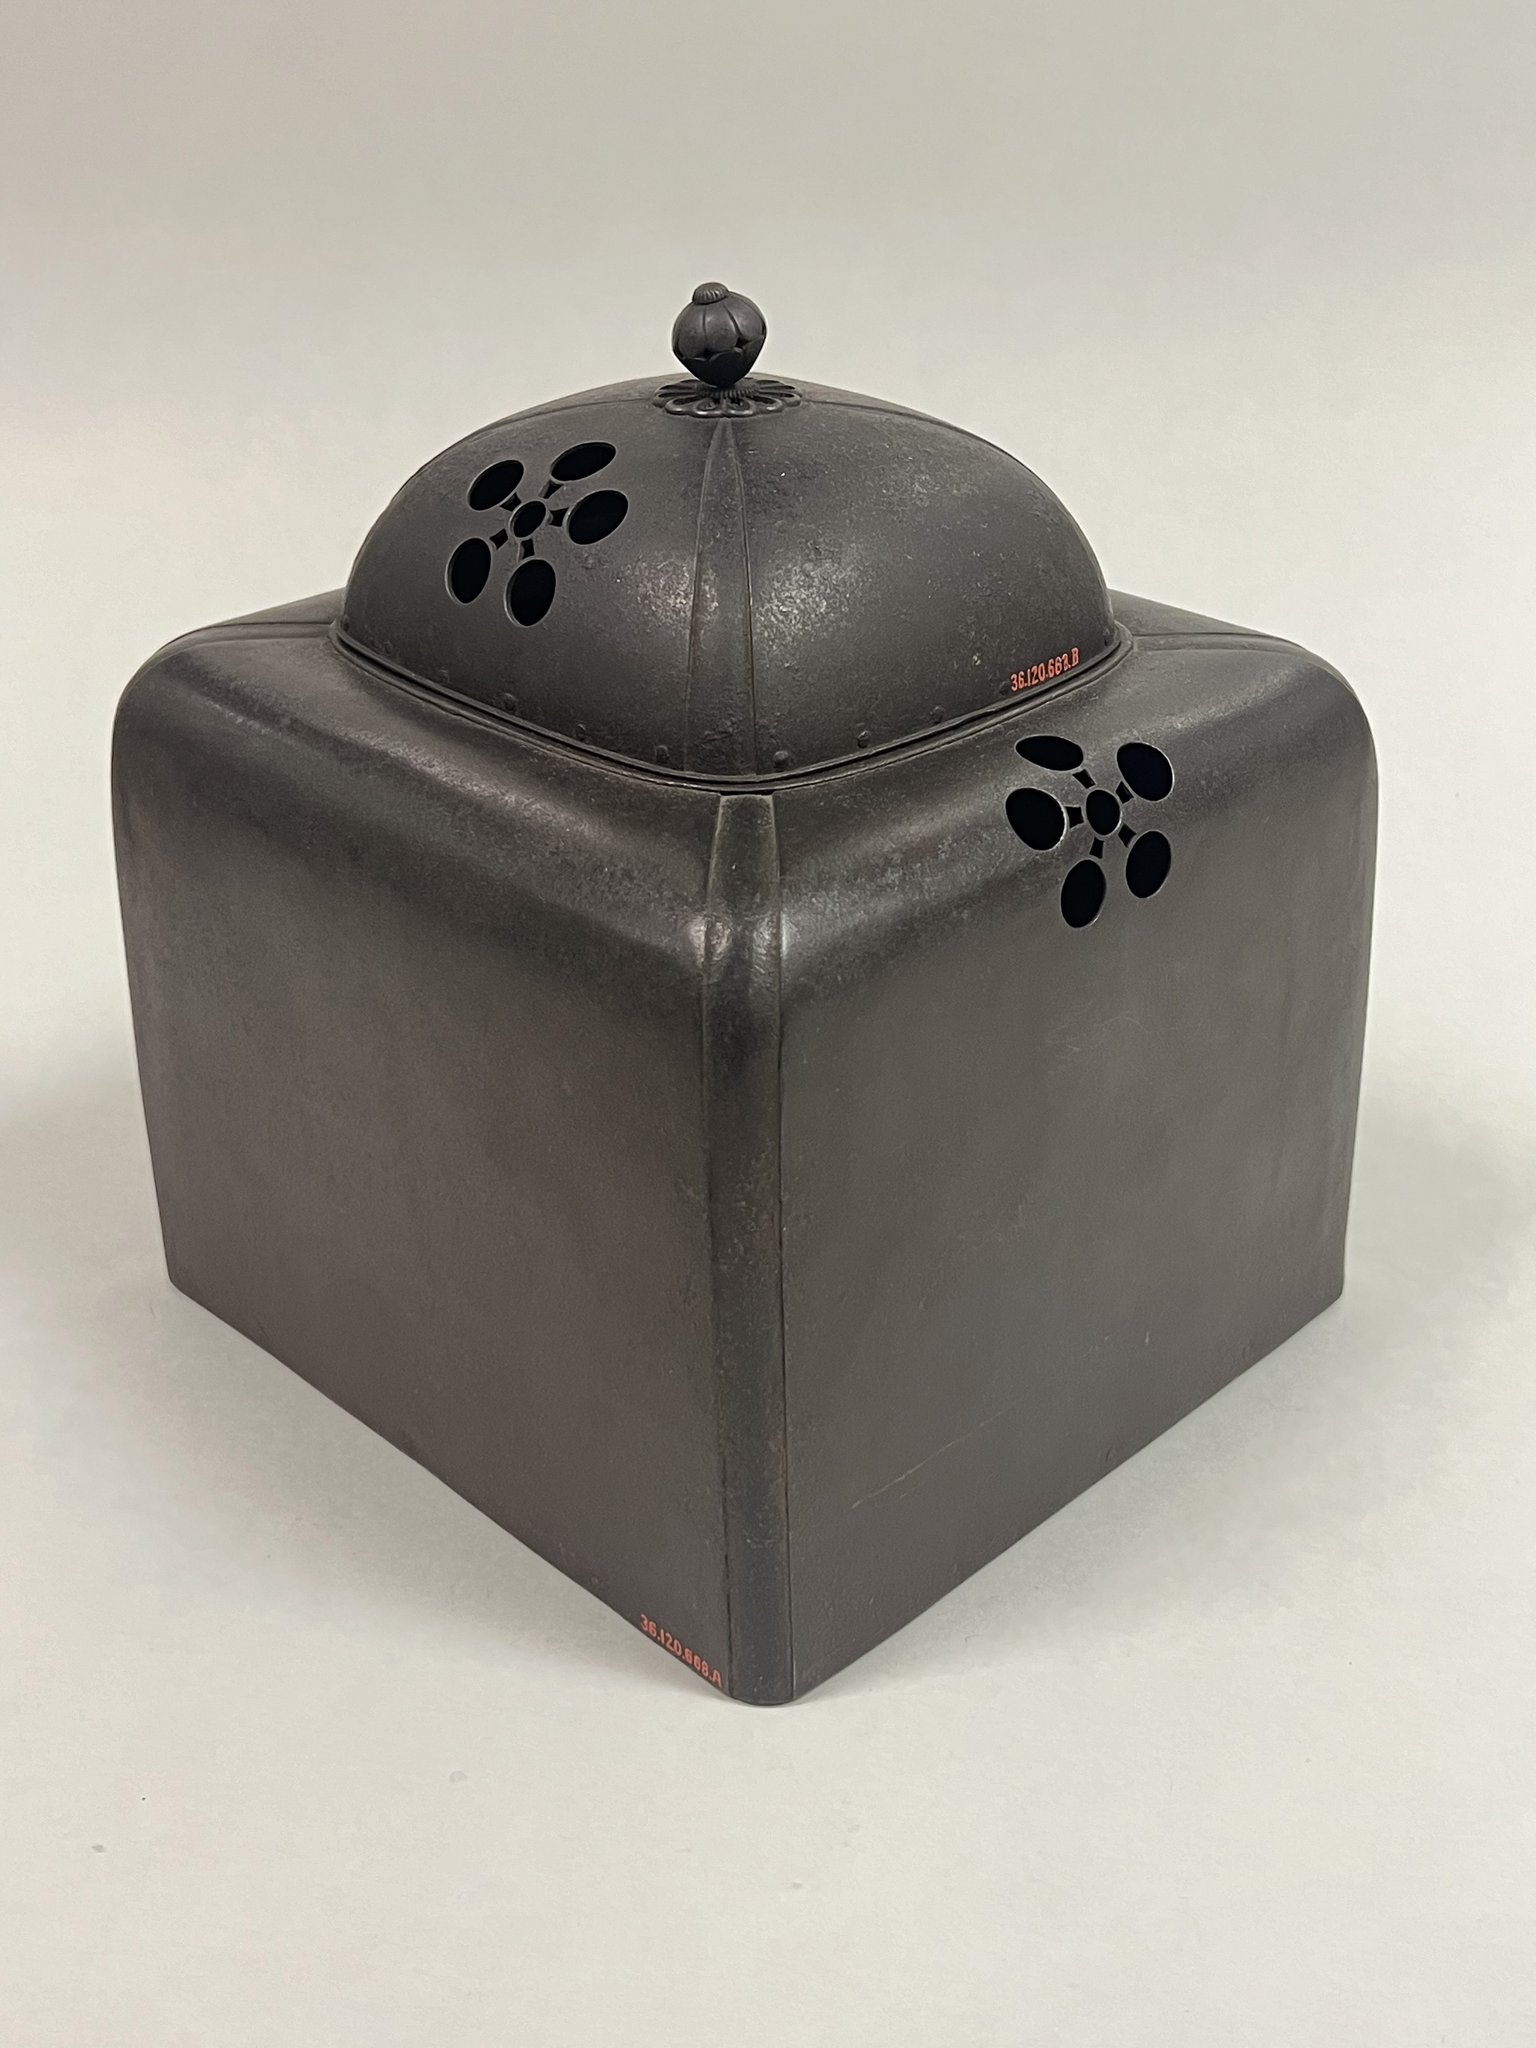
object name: charcoal burner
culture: japanese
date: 1701-1800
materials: iron